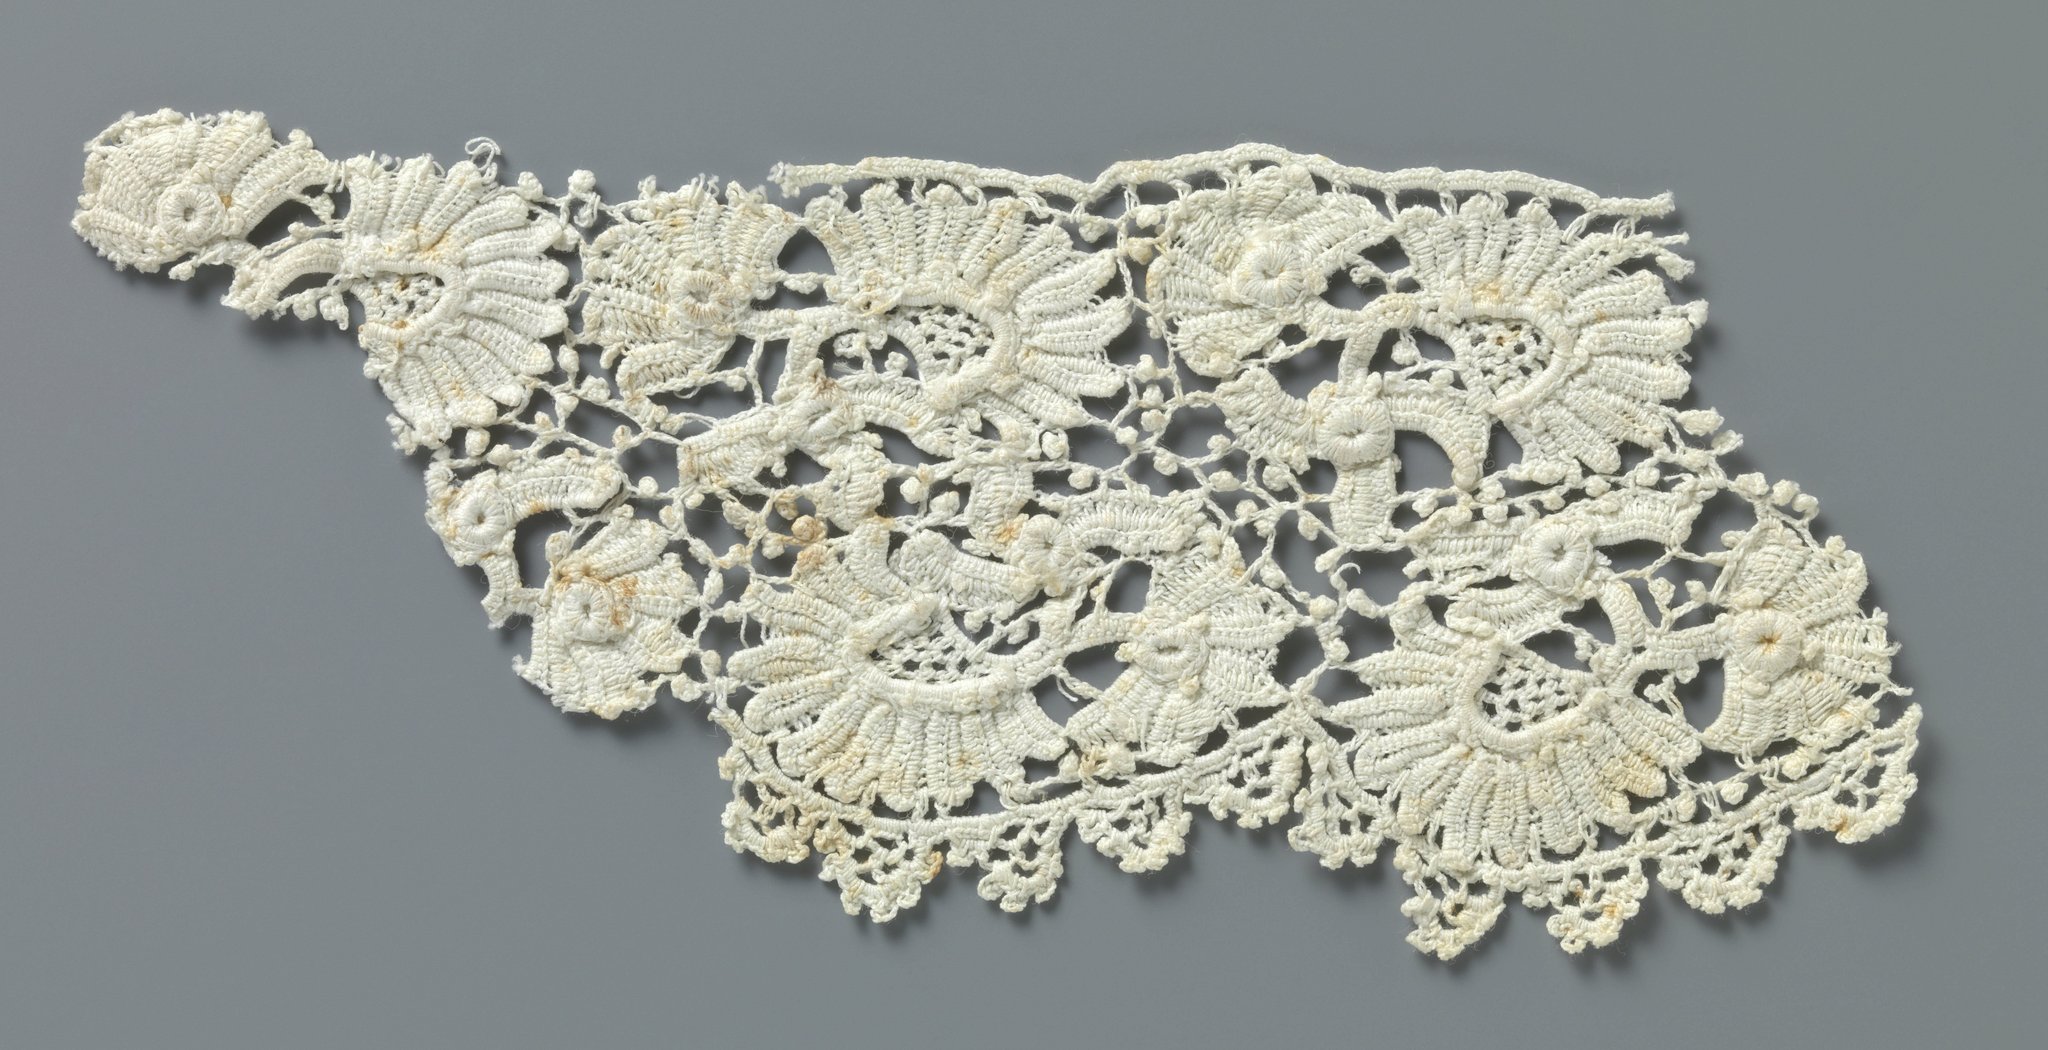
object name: strip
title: Strook gehaakte kant met waaiervormige bloemen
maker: Anonymous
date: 1890-1909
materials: cotton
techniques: crocheted lace, irish crochet lace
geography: ireland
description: Het is een aanname dat deze Ierse gehaakte kant ook daadwerkelijk in Ierland is gemaakt. Ierse gehaakte kant kent zijn oorsprong rond 1760 en kwam vanaf 1840 in ontwikkeling. Aangezien volgens Martine Bruggeman (Kant in Europa) de Ierse haakindustrie aan het eind van de 19e eeuw gereorganiseerd werd en in populariteit groeide, is het hier beschreven stuk gedateerd rond 1890, tot 1909 vanwege de datering in het eerste decennium van populariteit van Ierse gehaakte kant volgens het Kantlexicon (Johan Coene).